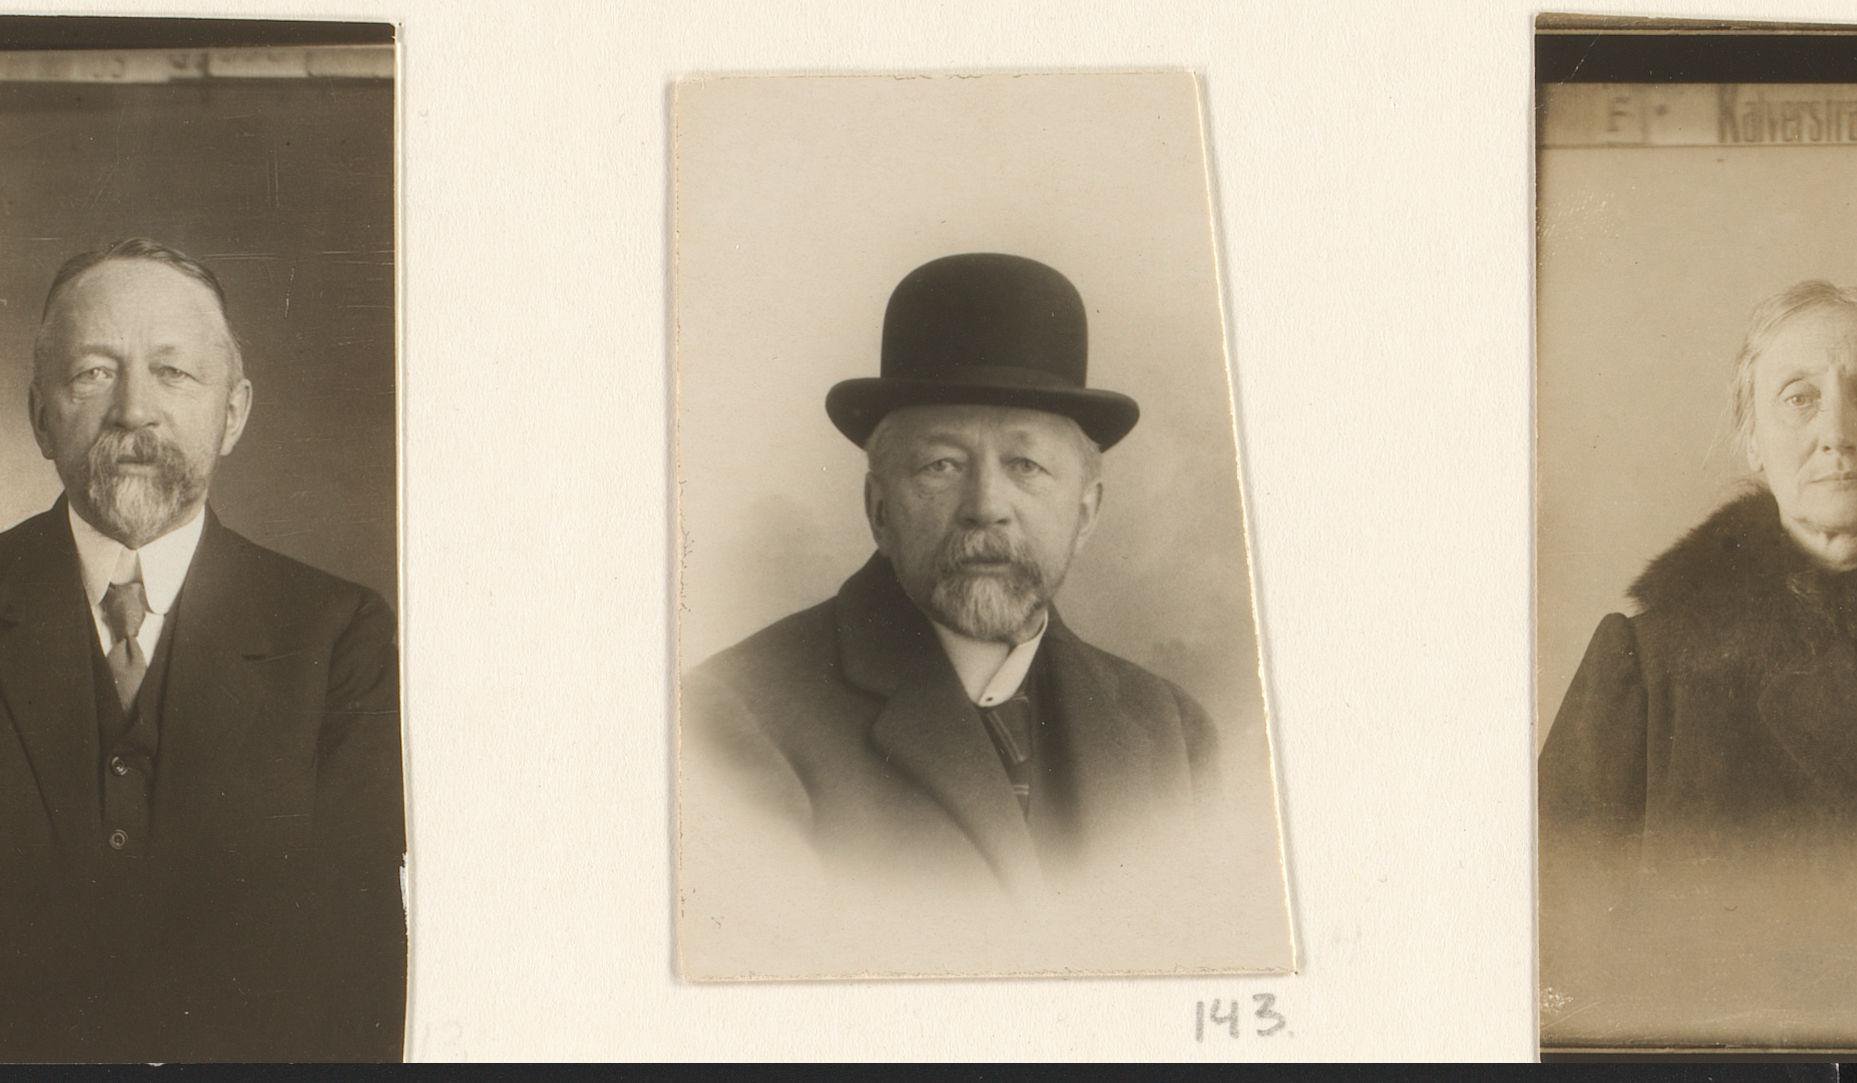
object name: photograph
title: Andries Bonger op middelbare leeftijd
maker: Anonymous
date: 1930-1936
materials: cardboard, paper, photographic support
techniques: gelatin silver print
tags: amsterdam, andries bonger, historical persons